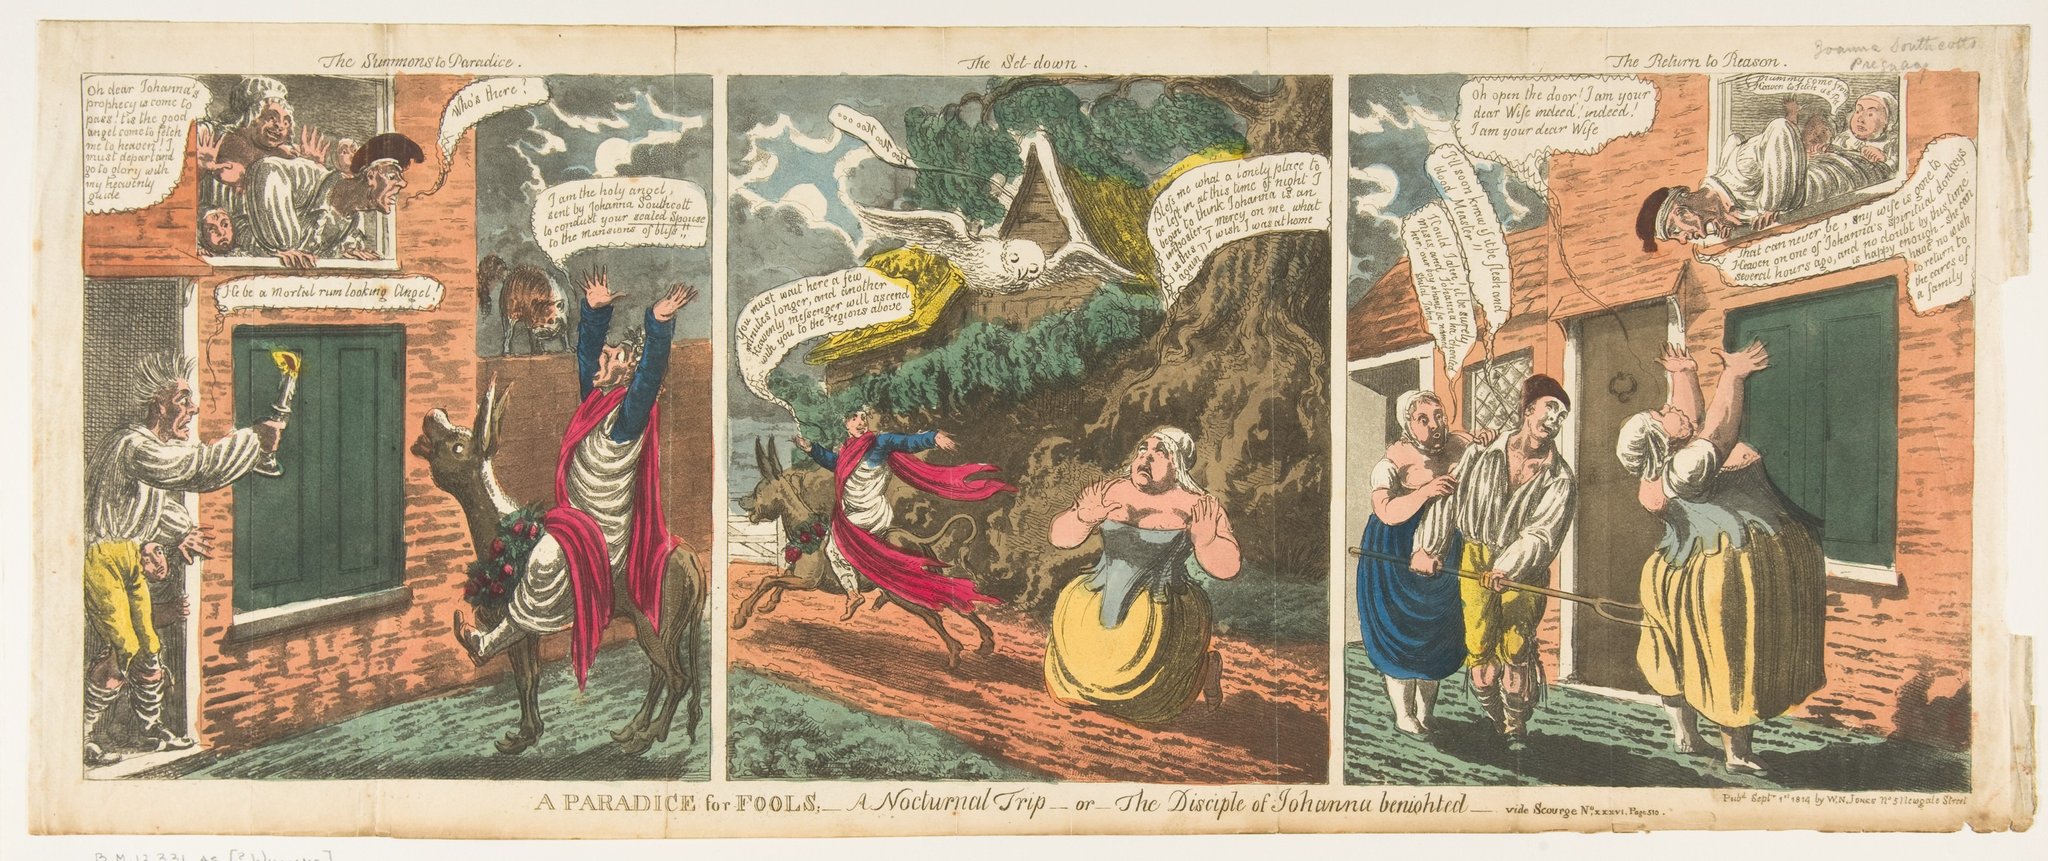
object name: print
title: A Paradice [sic] for Fools–A Nocturnal Trip–or–The Disciple of Johanna benighted–vided Scourge No. XXXVI, page 510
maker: charles williams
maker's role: artist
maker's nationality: british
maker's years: 1750-1850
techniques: etching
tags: satire,men,women,donkeys